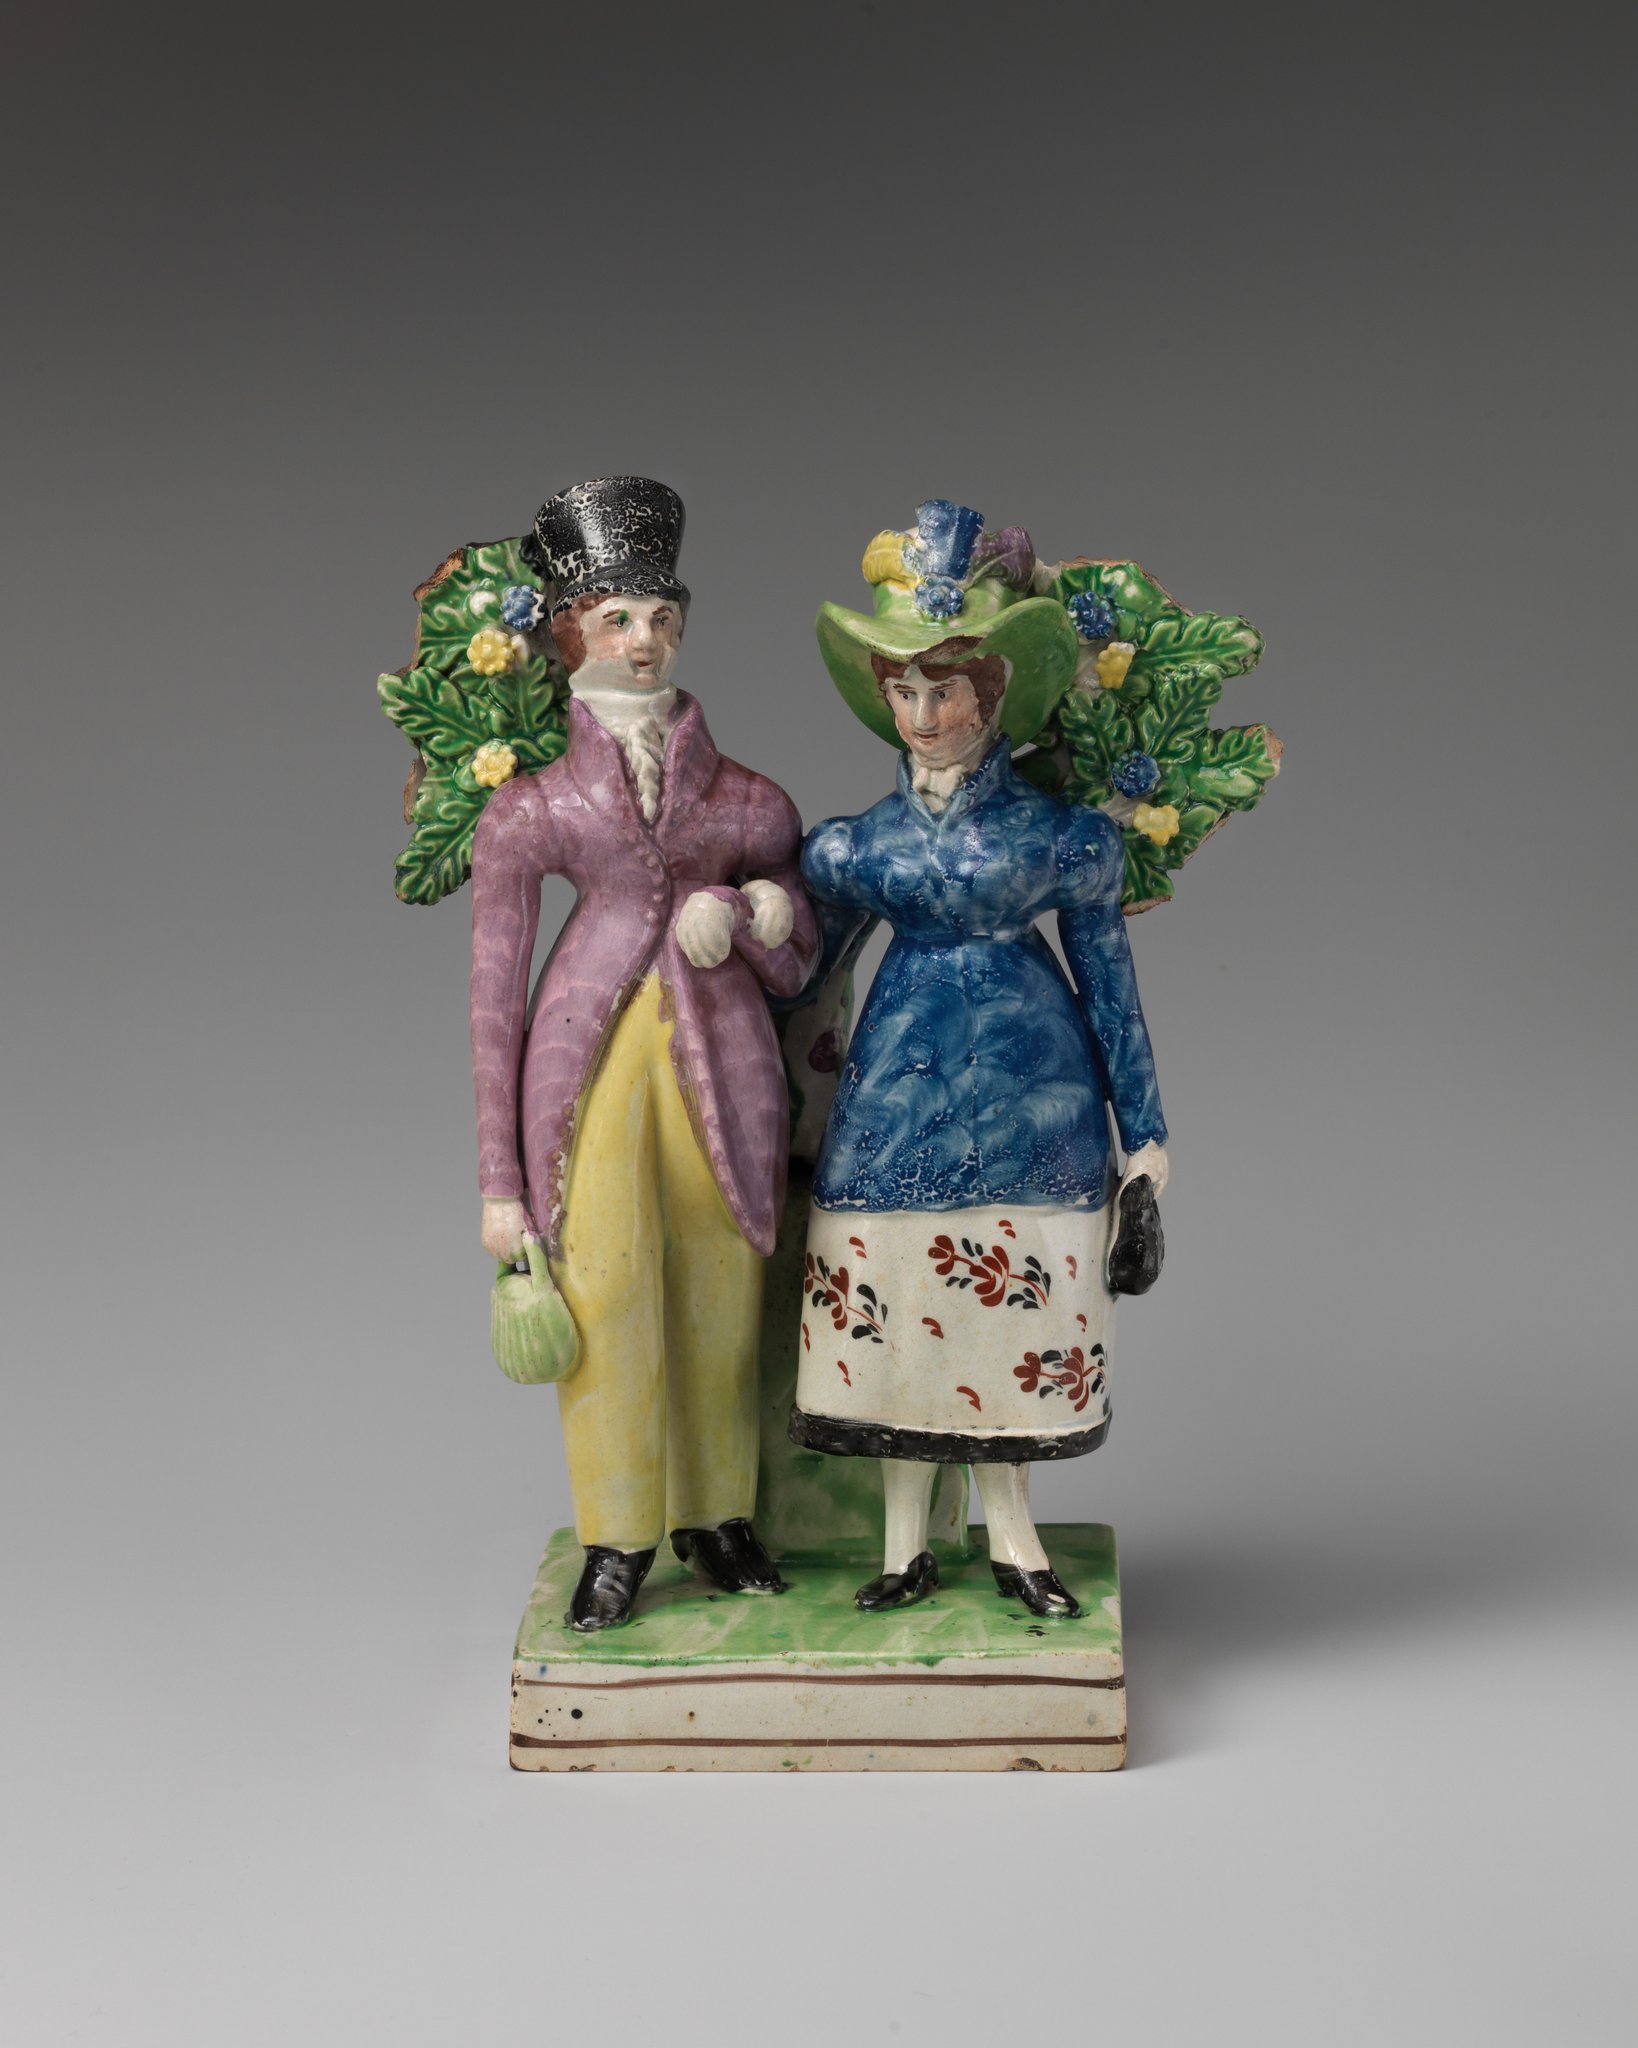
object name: group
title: Man and woman standing near a tree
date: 1830-1840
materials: pottery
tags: men,women